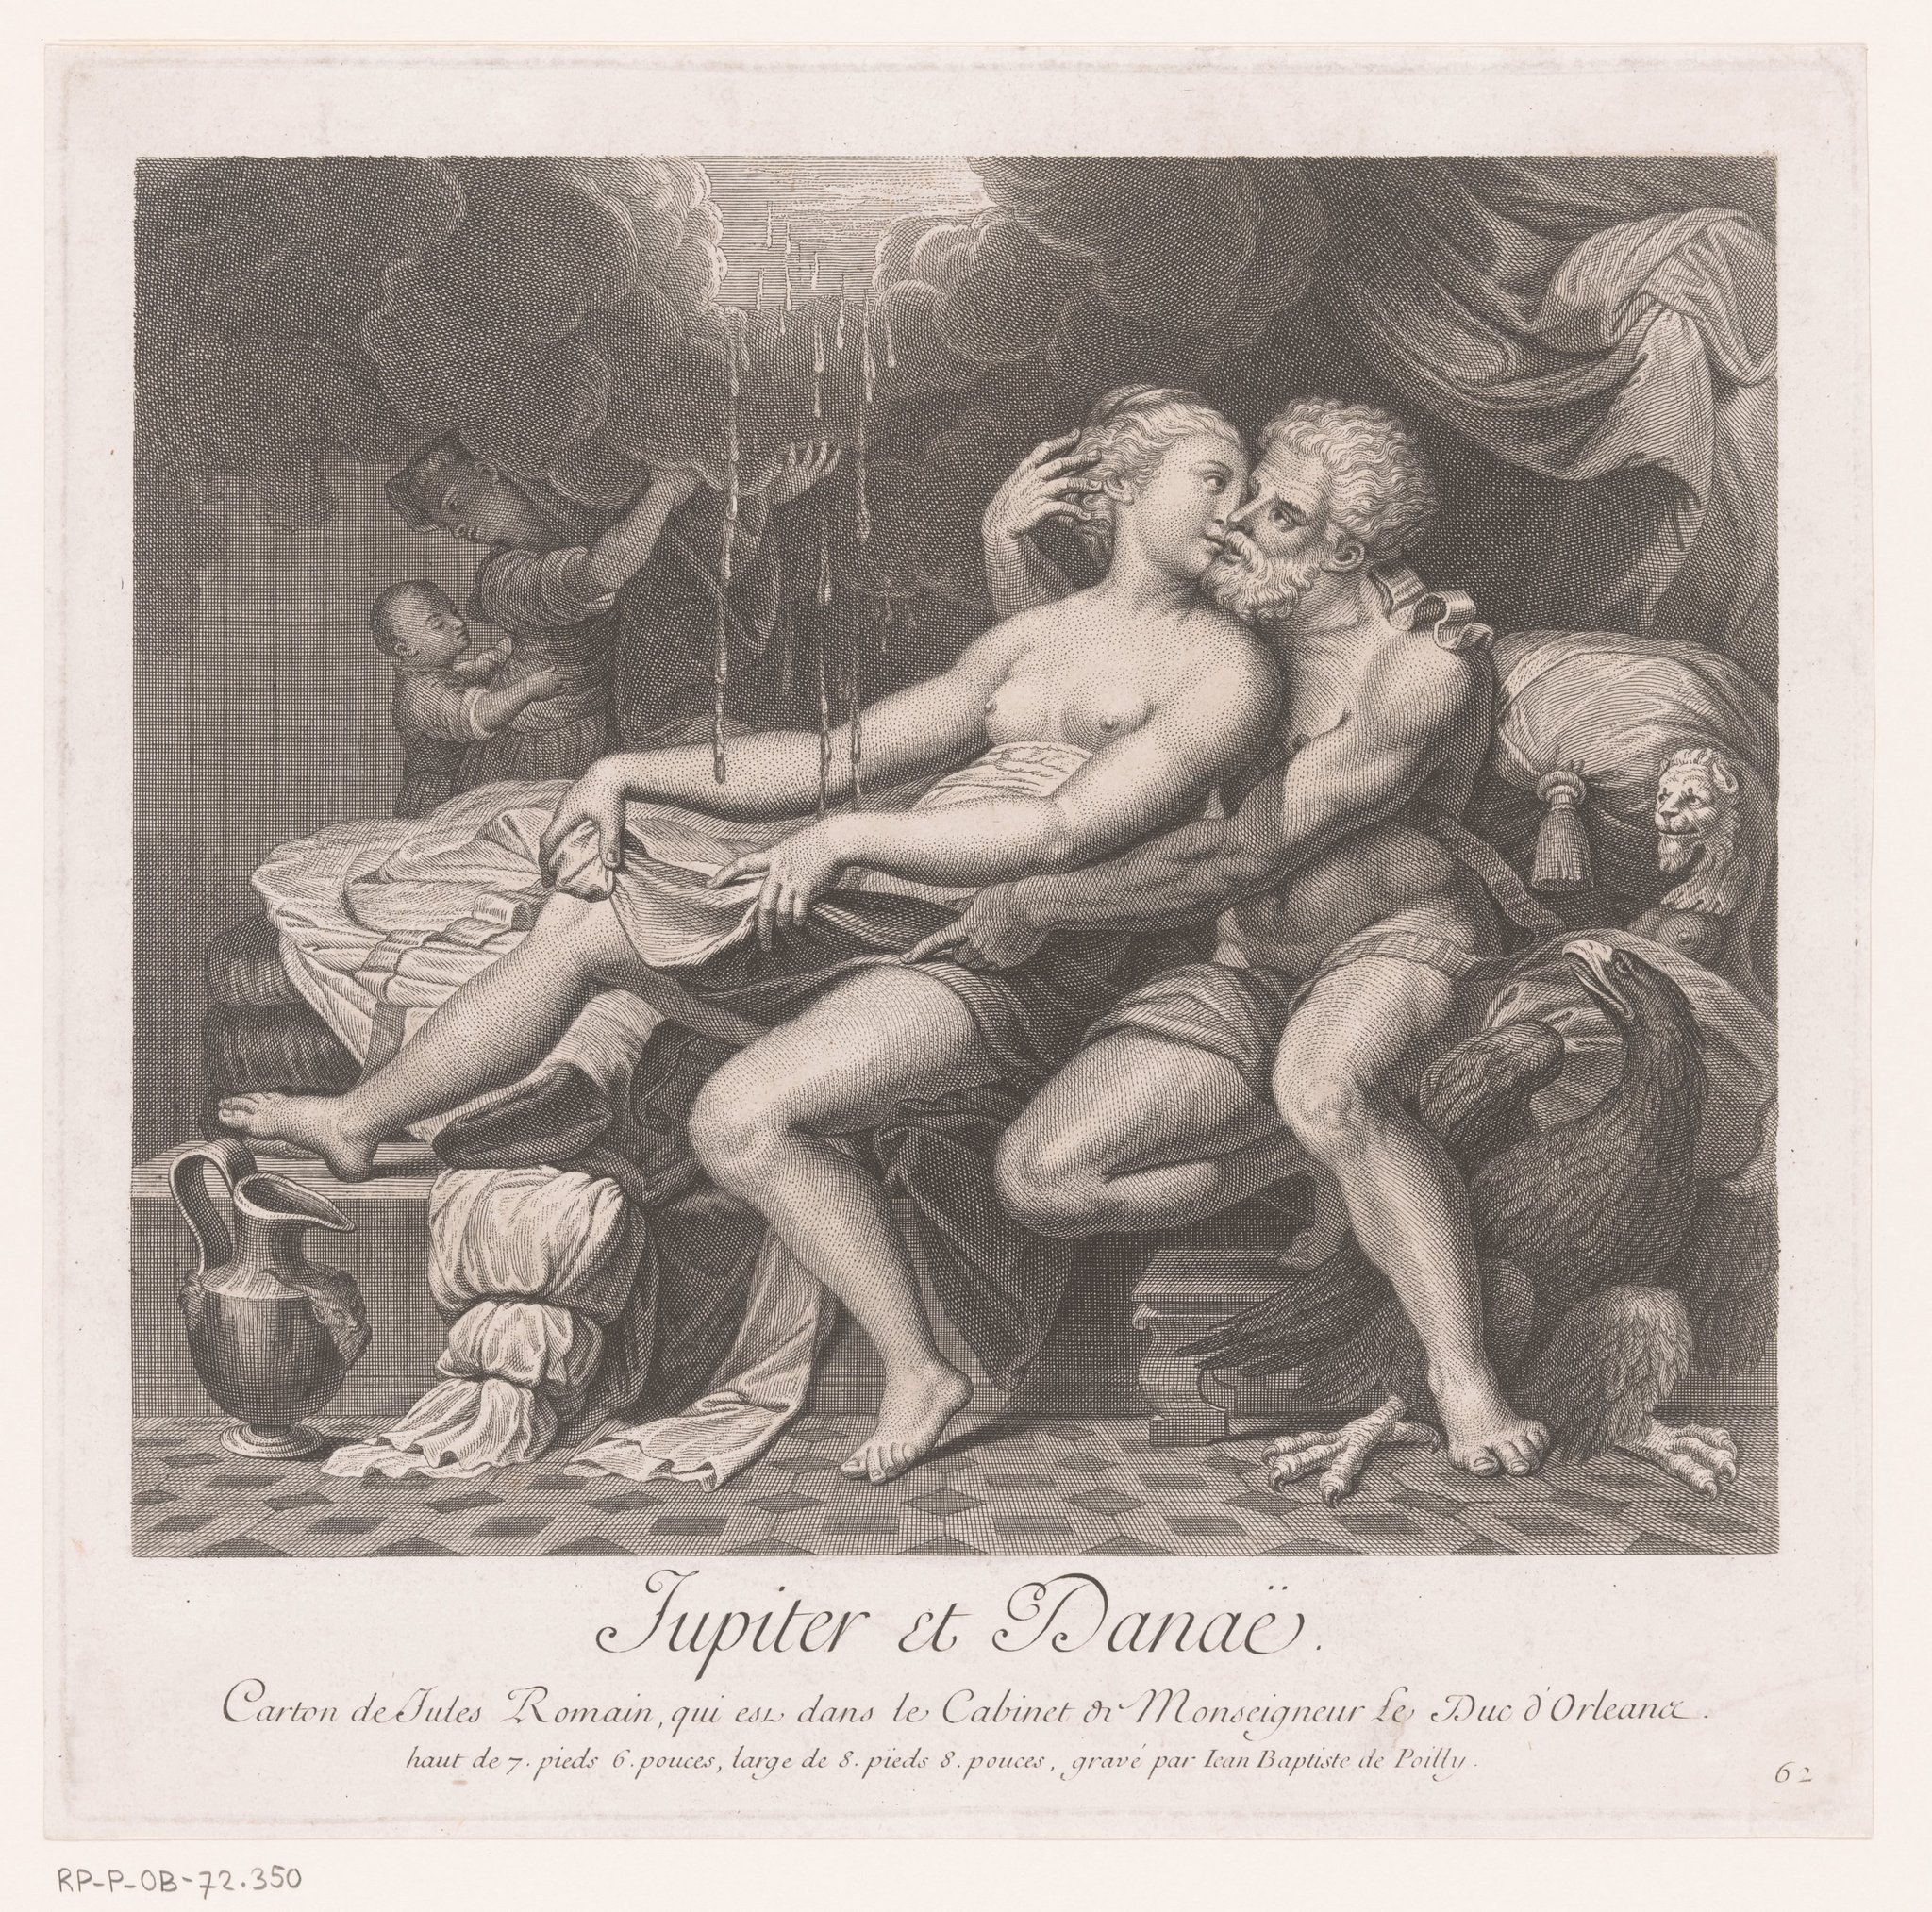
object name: print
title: Jupiter en Danaë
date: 1679-1728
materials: paper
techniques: engraving, etching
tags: jupiter wooing danae; she is usually lying in bed receiving a shower of gold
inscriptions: collector's mark: Lugt 2228